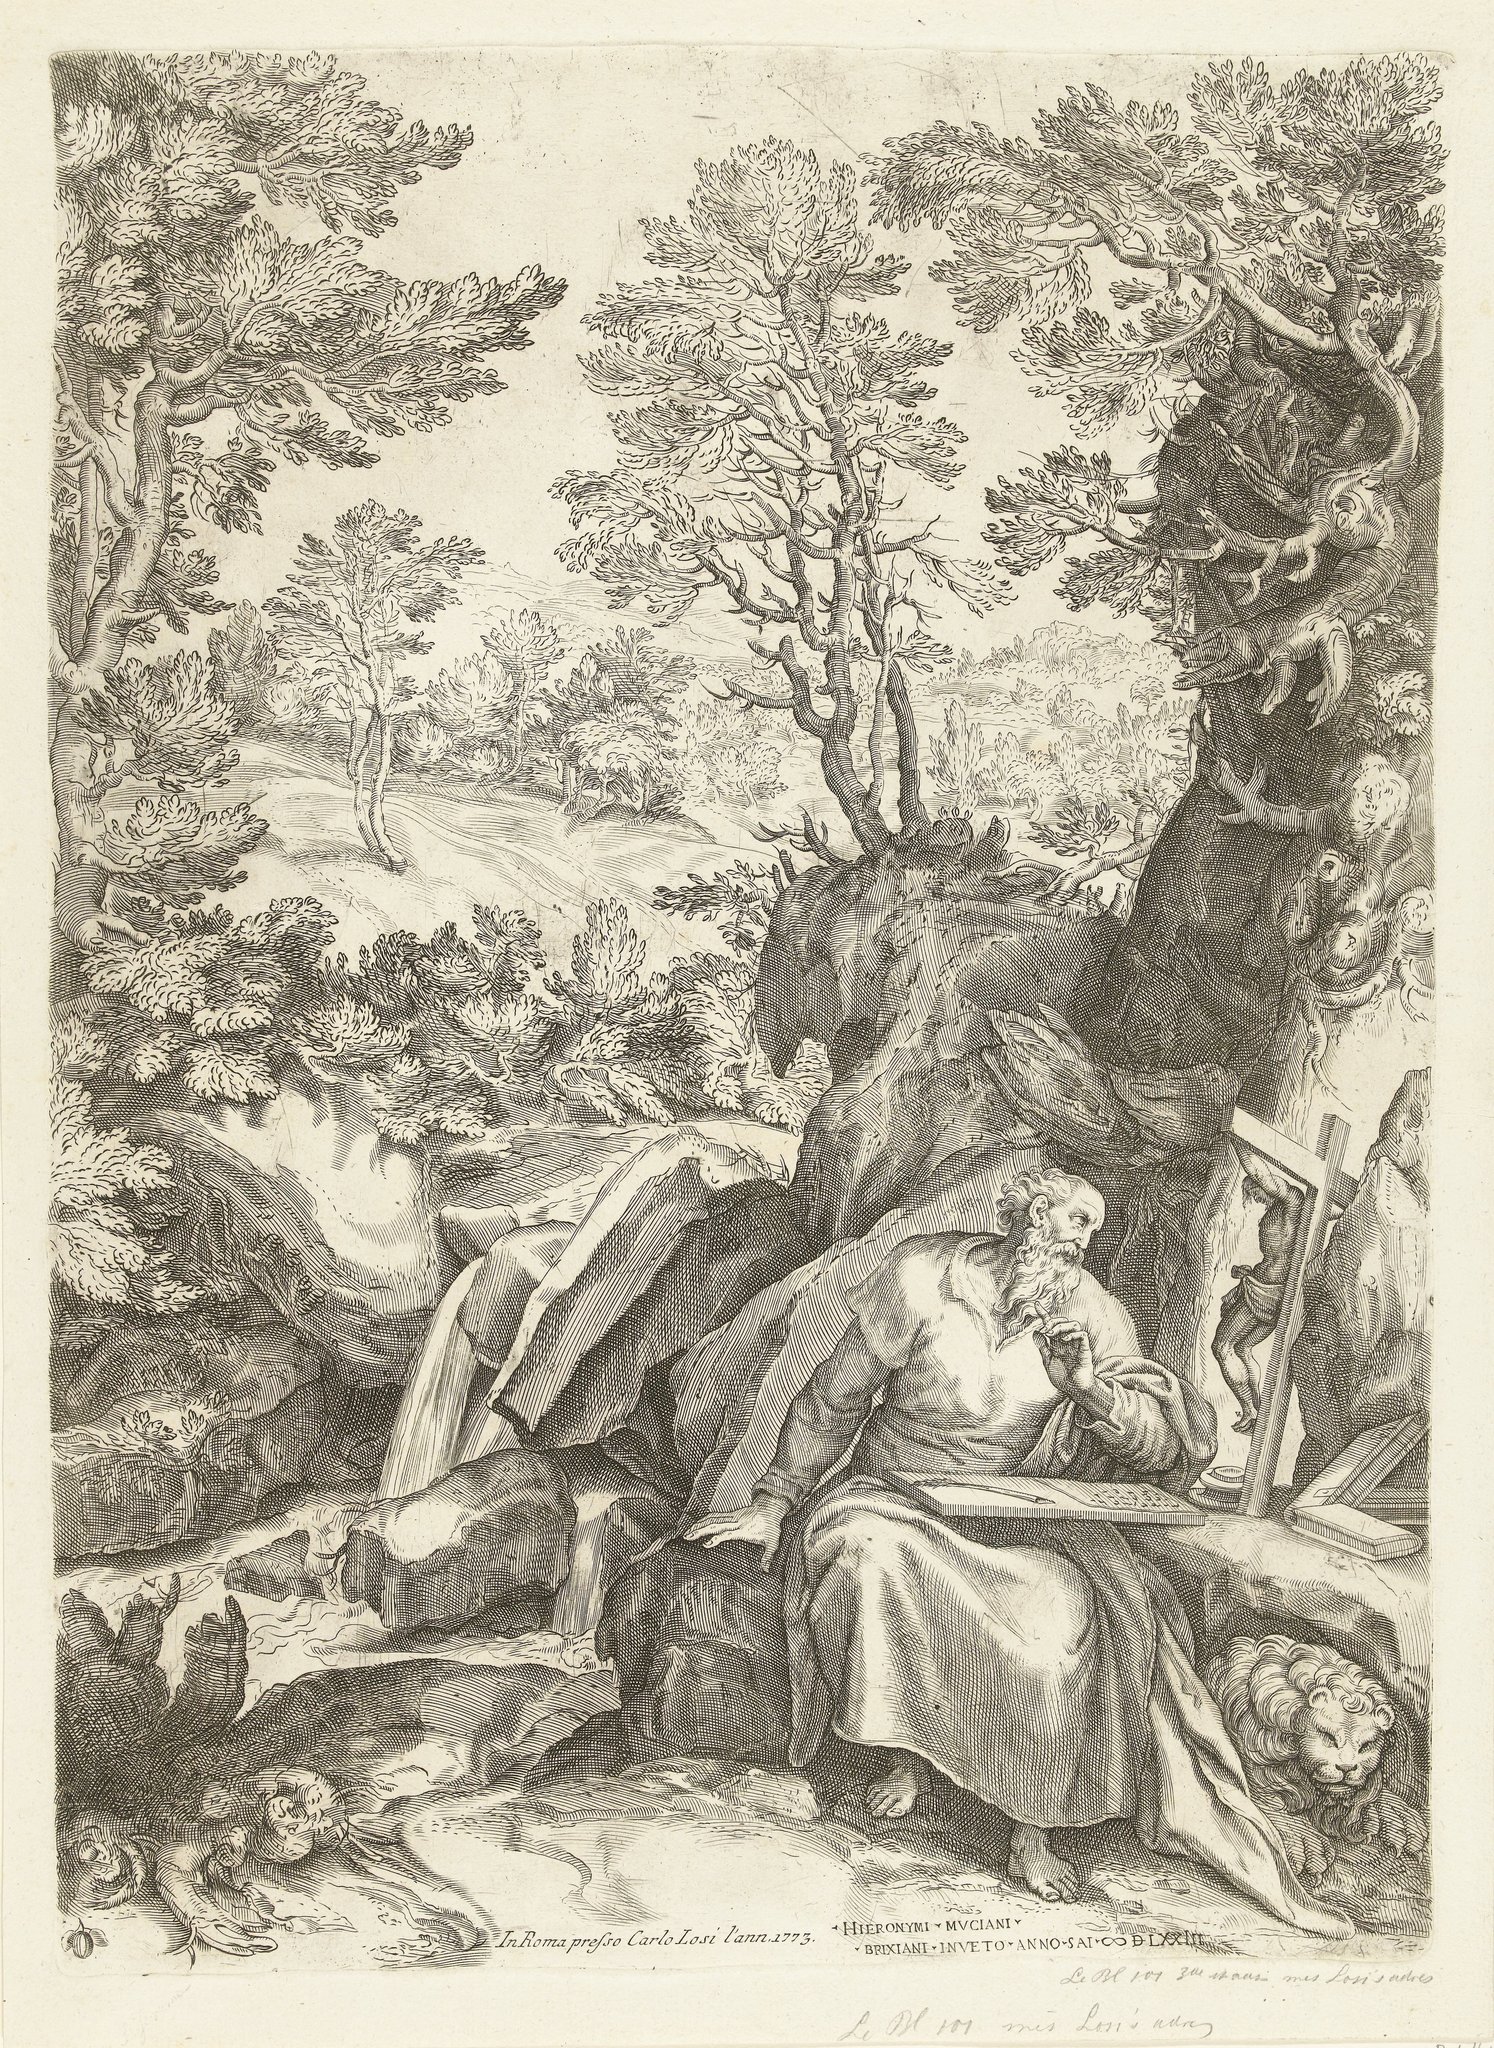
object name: print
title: Landschap met de H. Hieronymus die de bijbel vertaalt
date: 1573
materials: paper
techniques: engraving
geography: rome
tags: st. jerome translating the old and the new testament into latin (the vulgate)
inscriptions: collector's mark: Lugt 2228